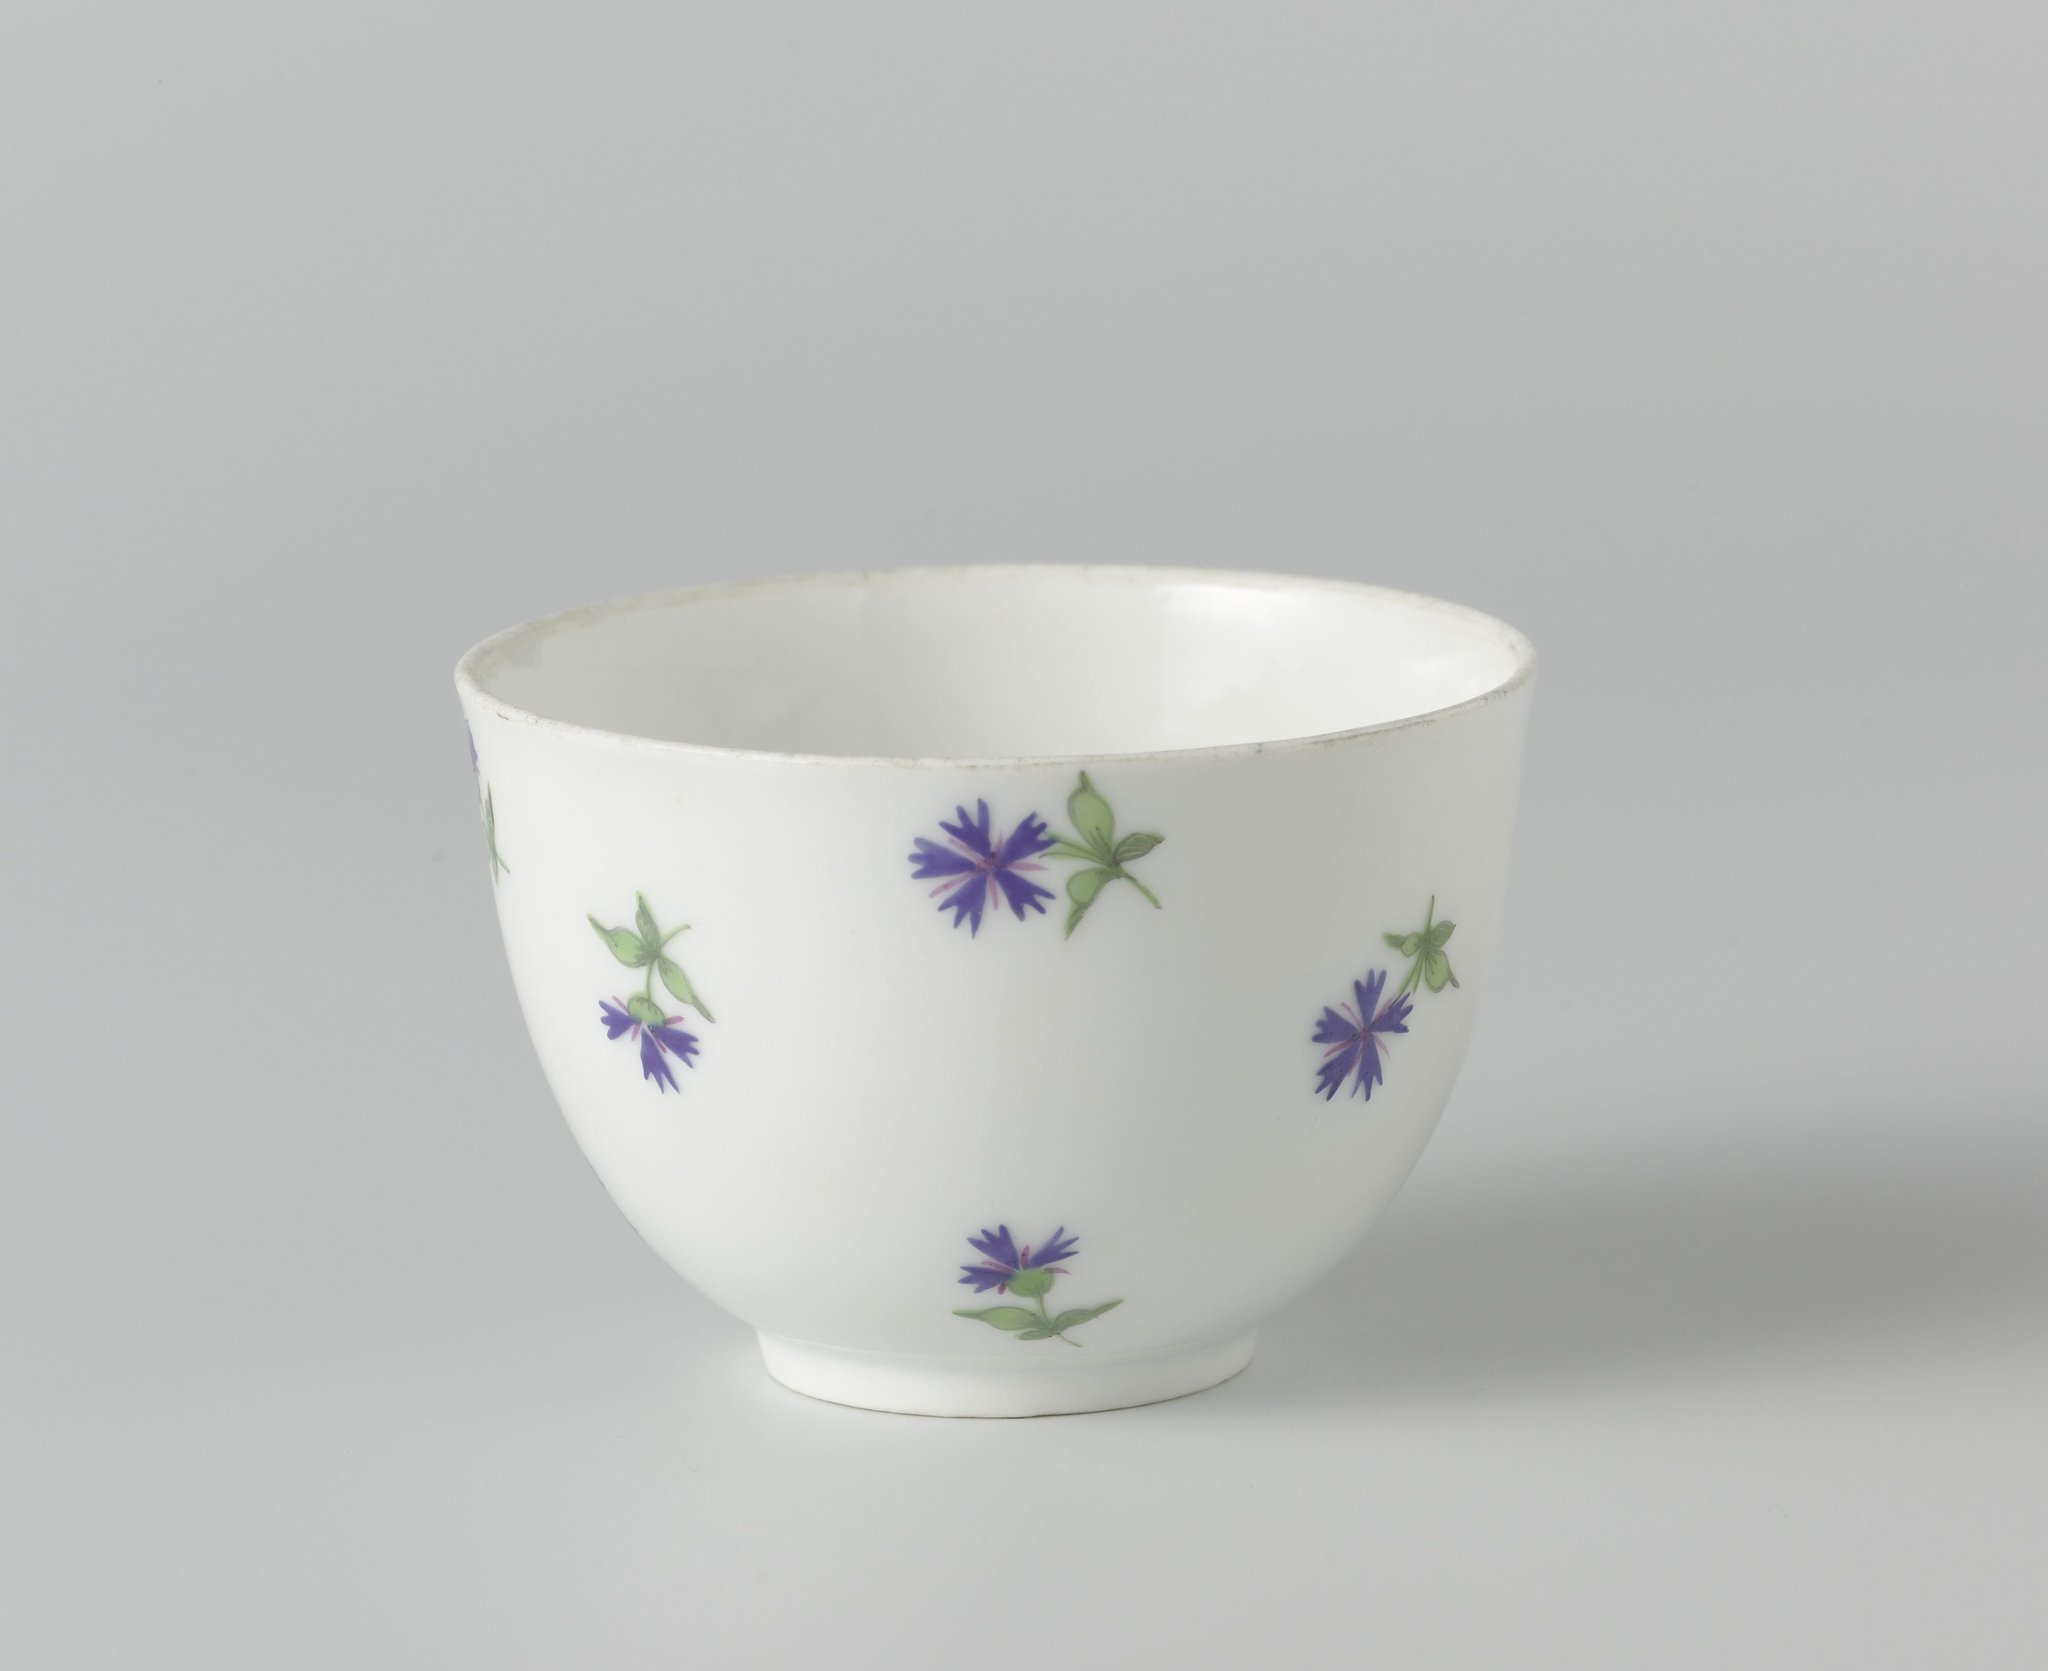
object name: cup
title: Kop, beschilderd met korenbloemen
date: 1784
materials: porcelain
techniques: painted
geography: loosdrecht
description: Kop, versierd met korenbloemen. Gemerkt Amstel in blauw onder het glazuur en ingegrift L48